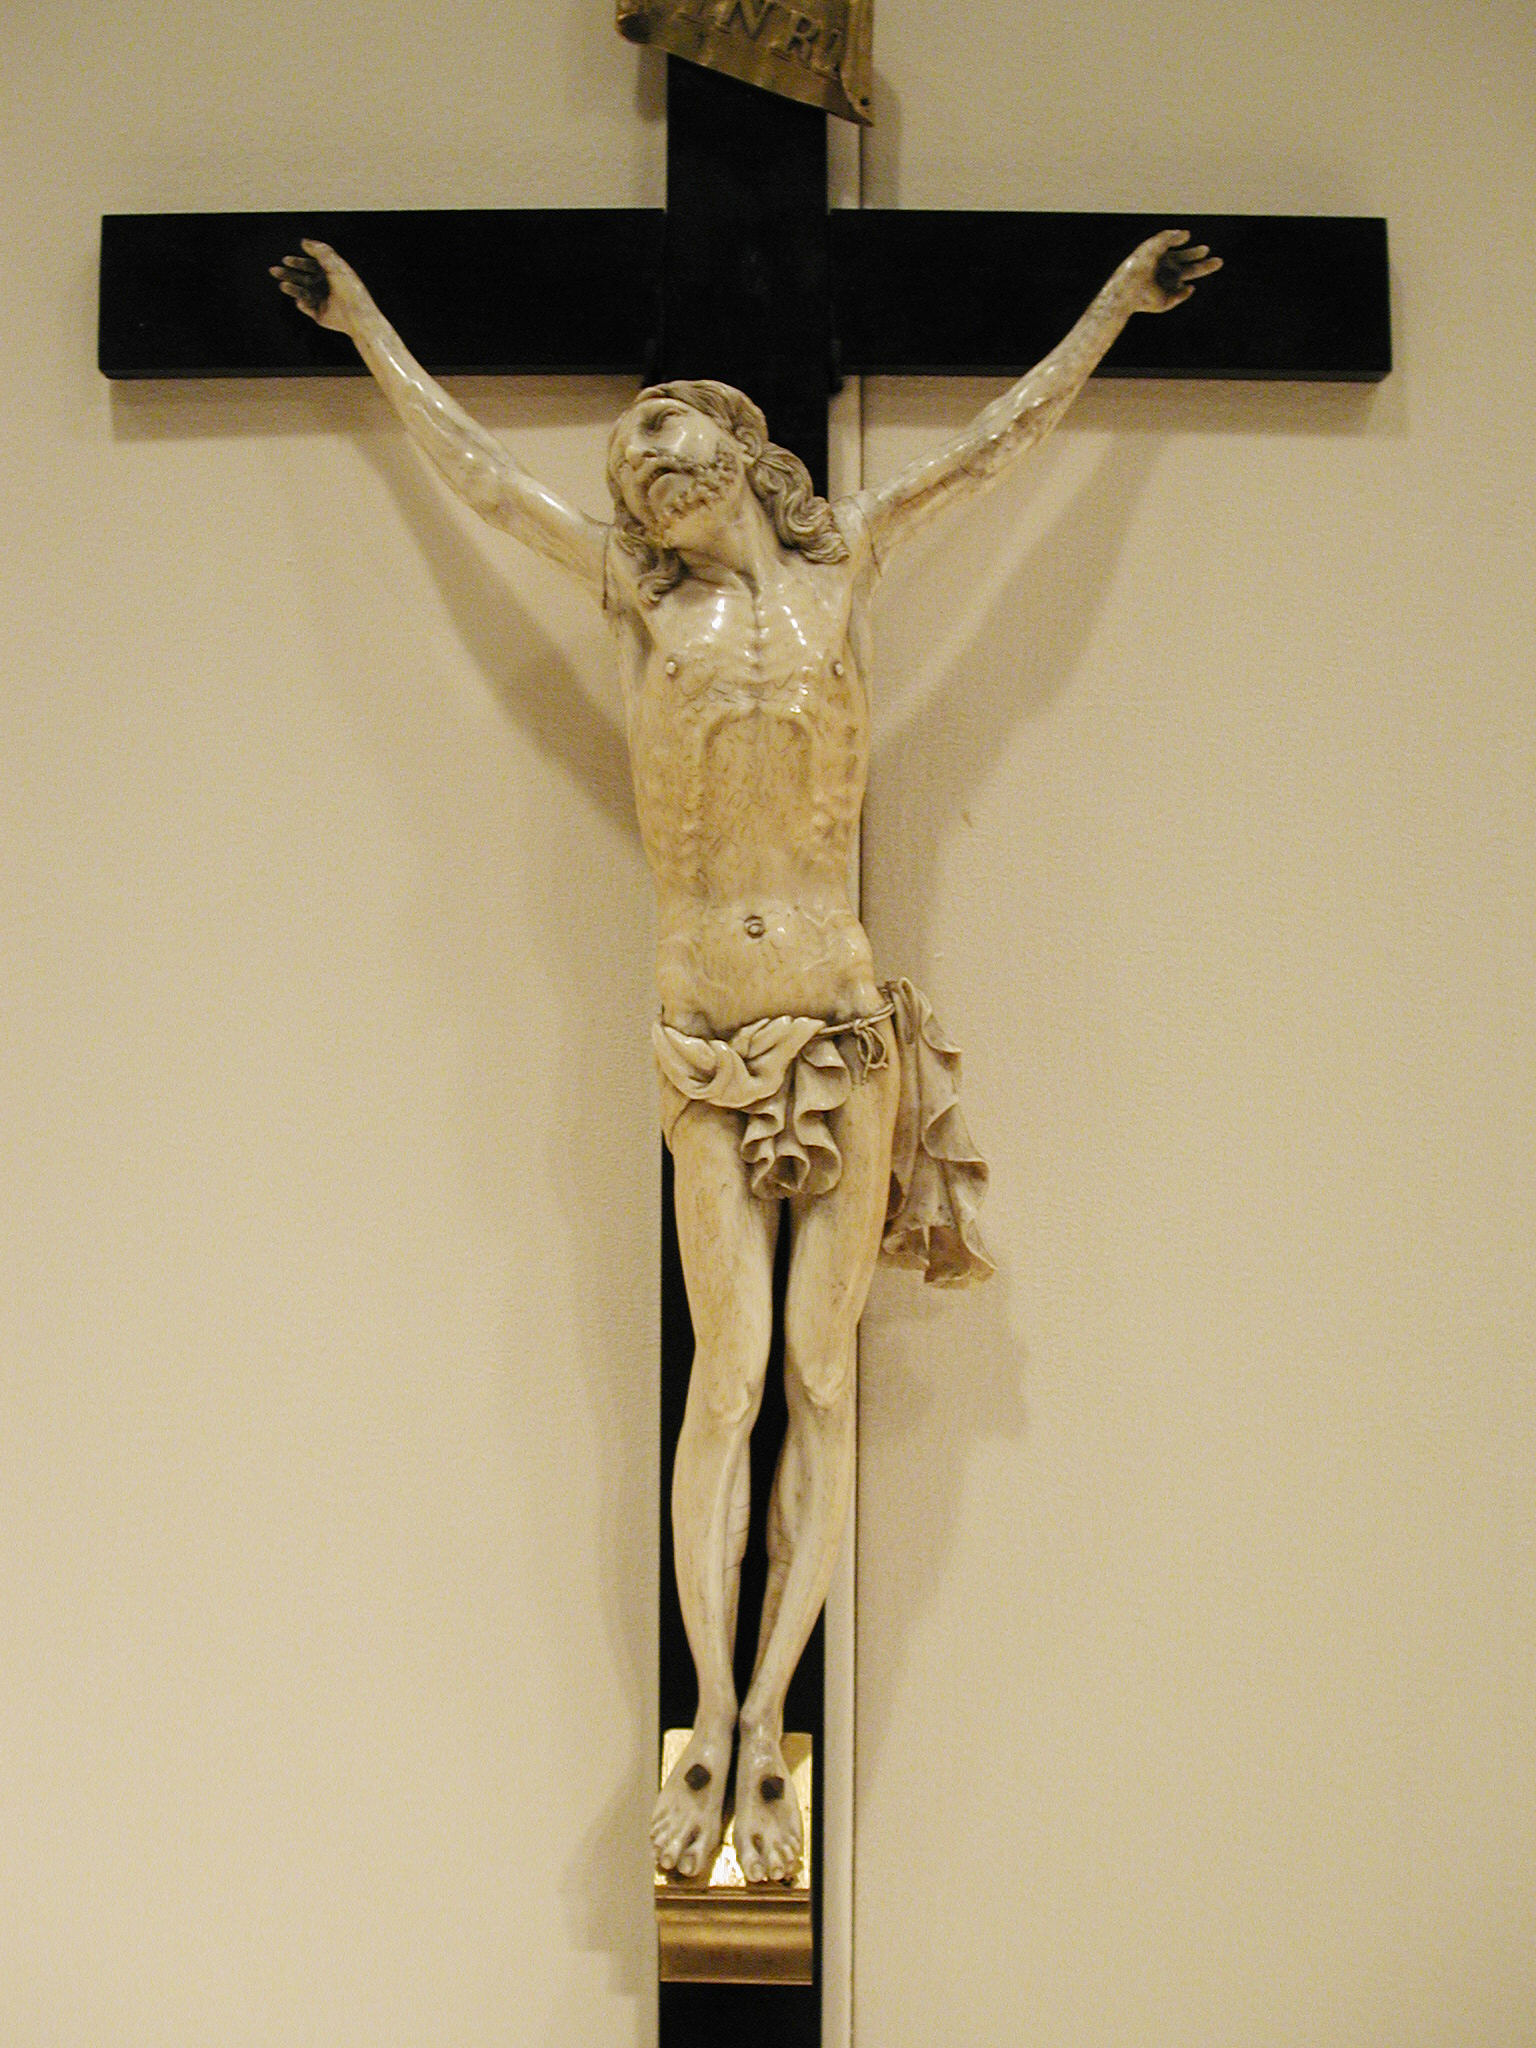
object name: crucifix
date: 1601-1700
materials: brass, wood, ivory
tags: jesus,crucifixion